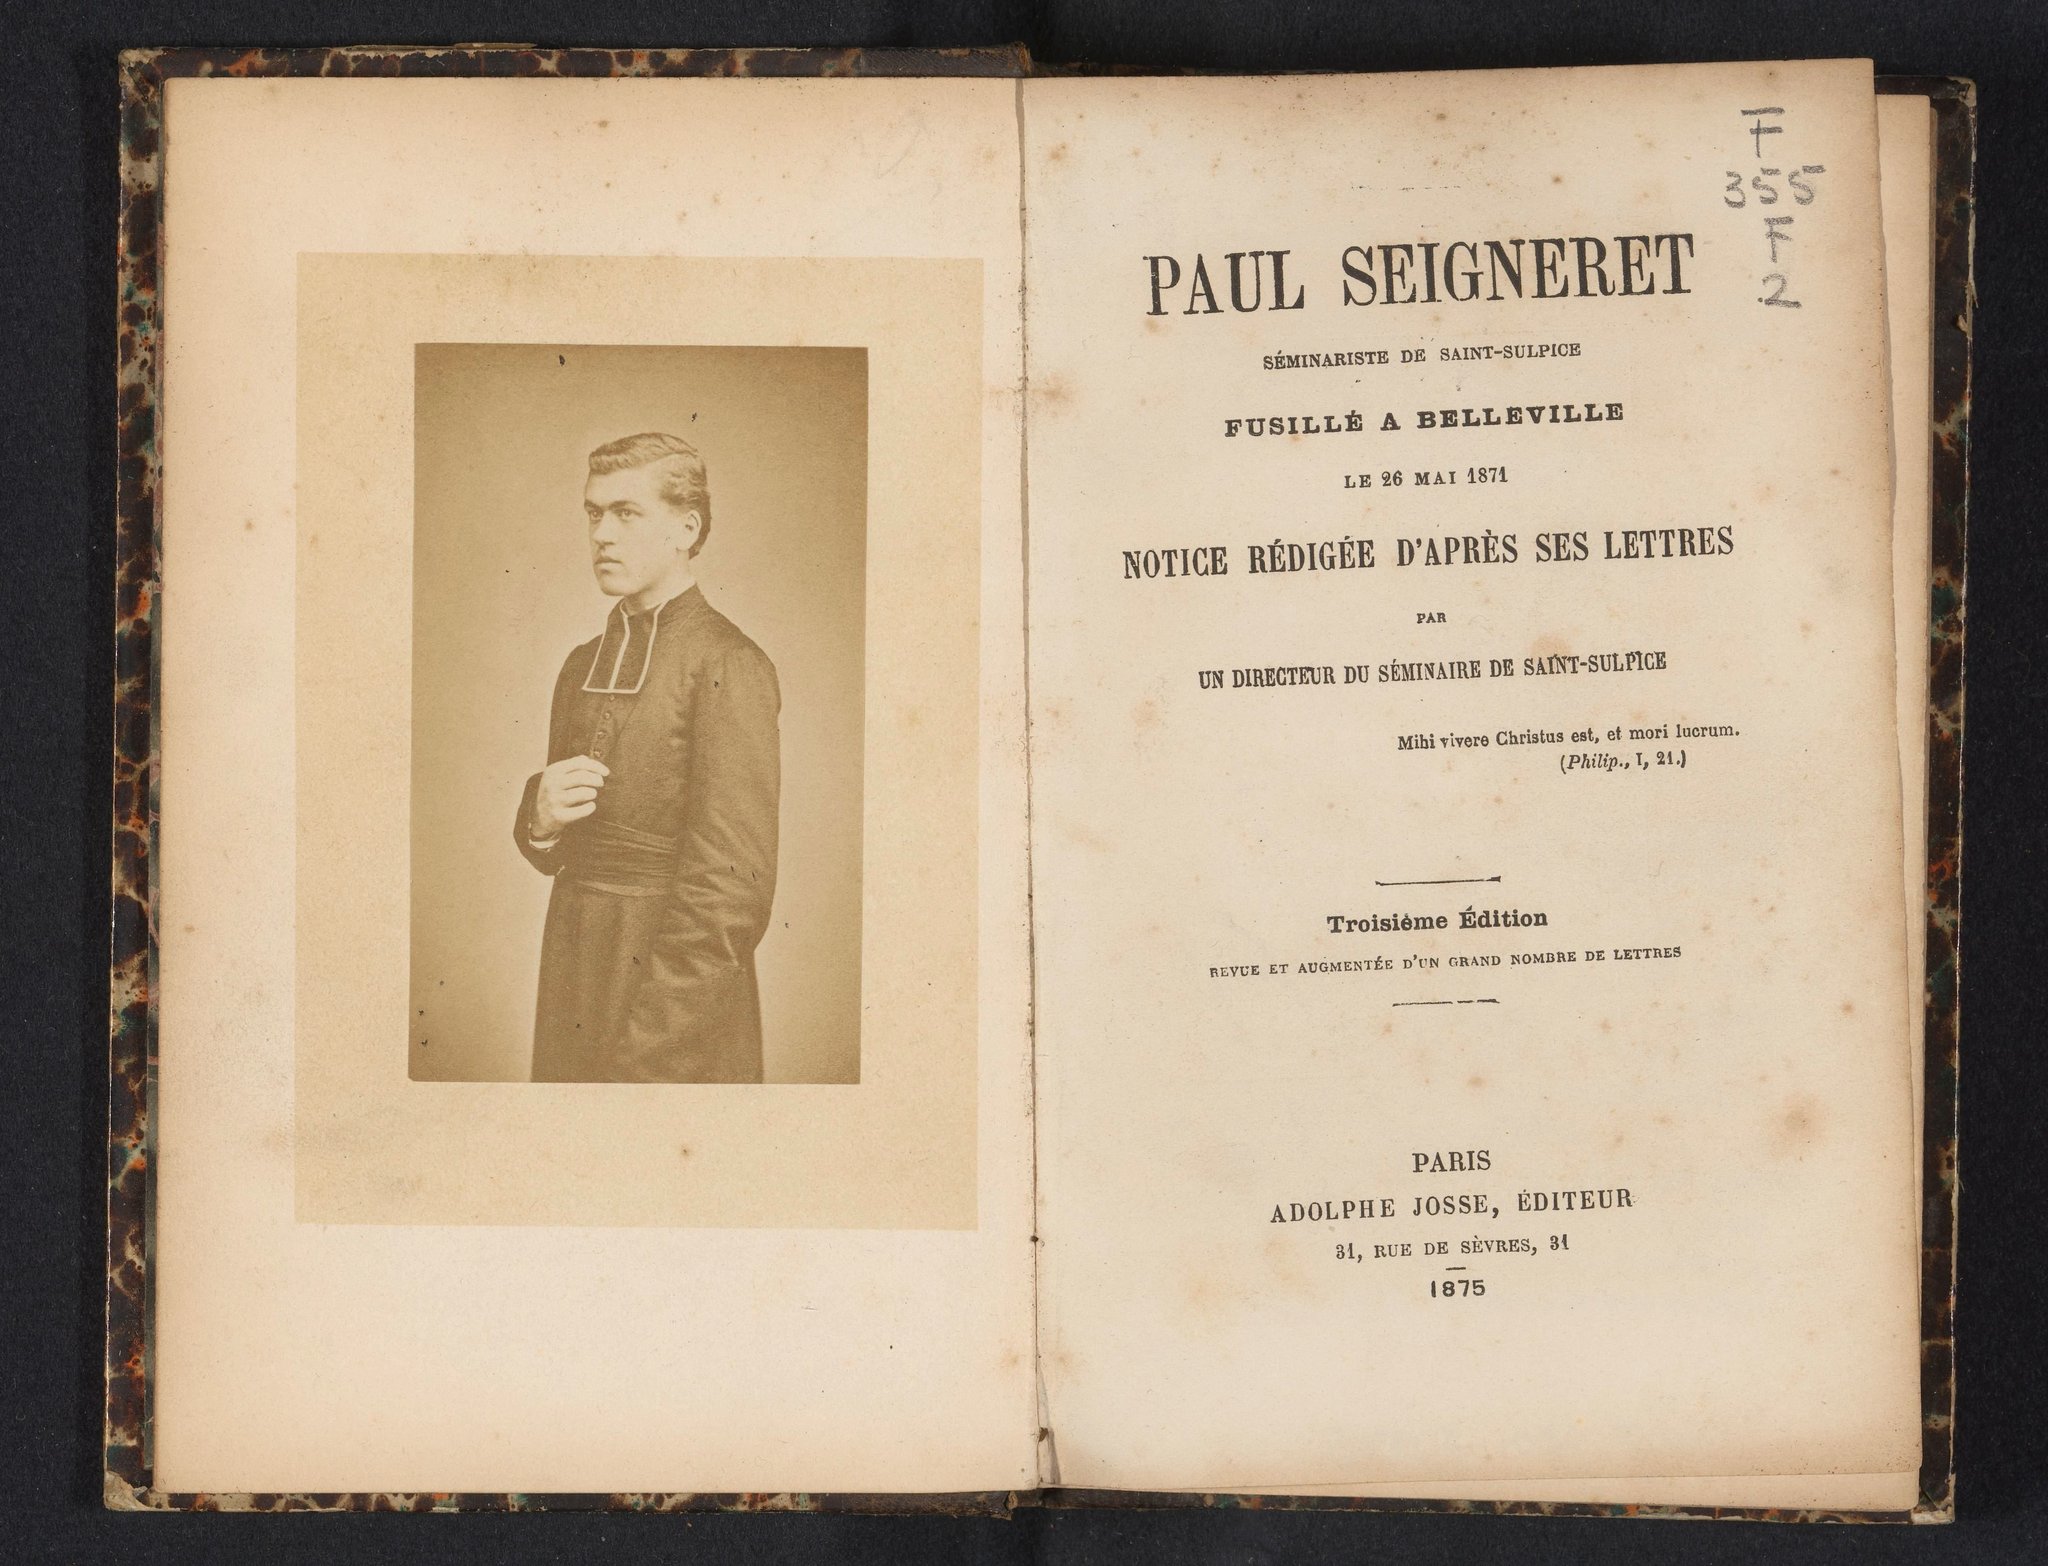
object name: book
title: Paul Seigneret séminariste de Saint-Sulpice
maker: adolphe josse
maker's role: publisher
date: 1875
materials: cardboard, leather, paper, photographic support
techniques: marbled paper, albumen print, printing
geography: paris